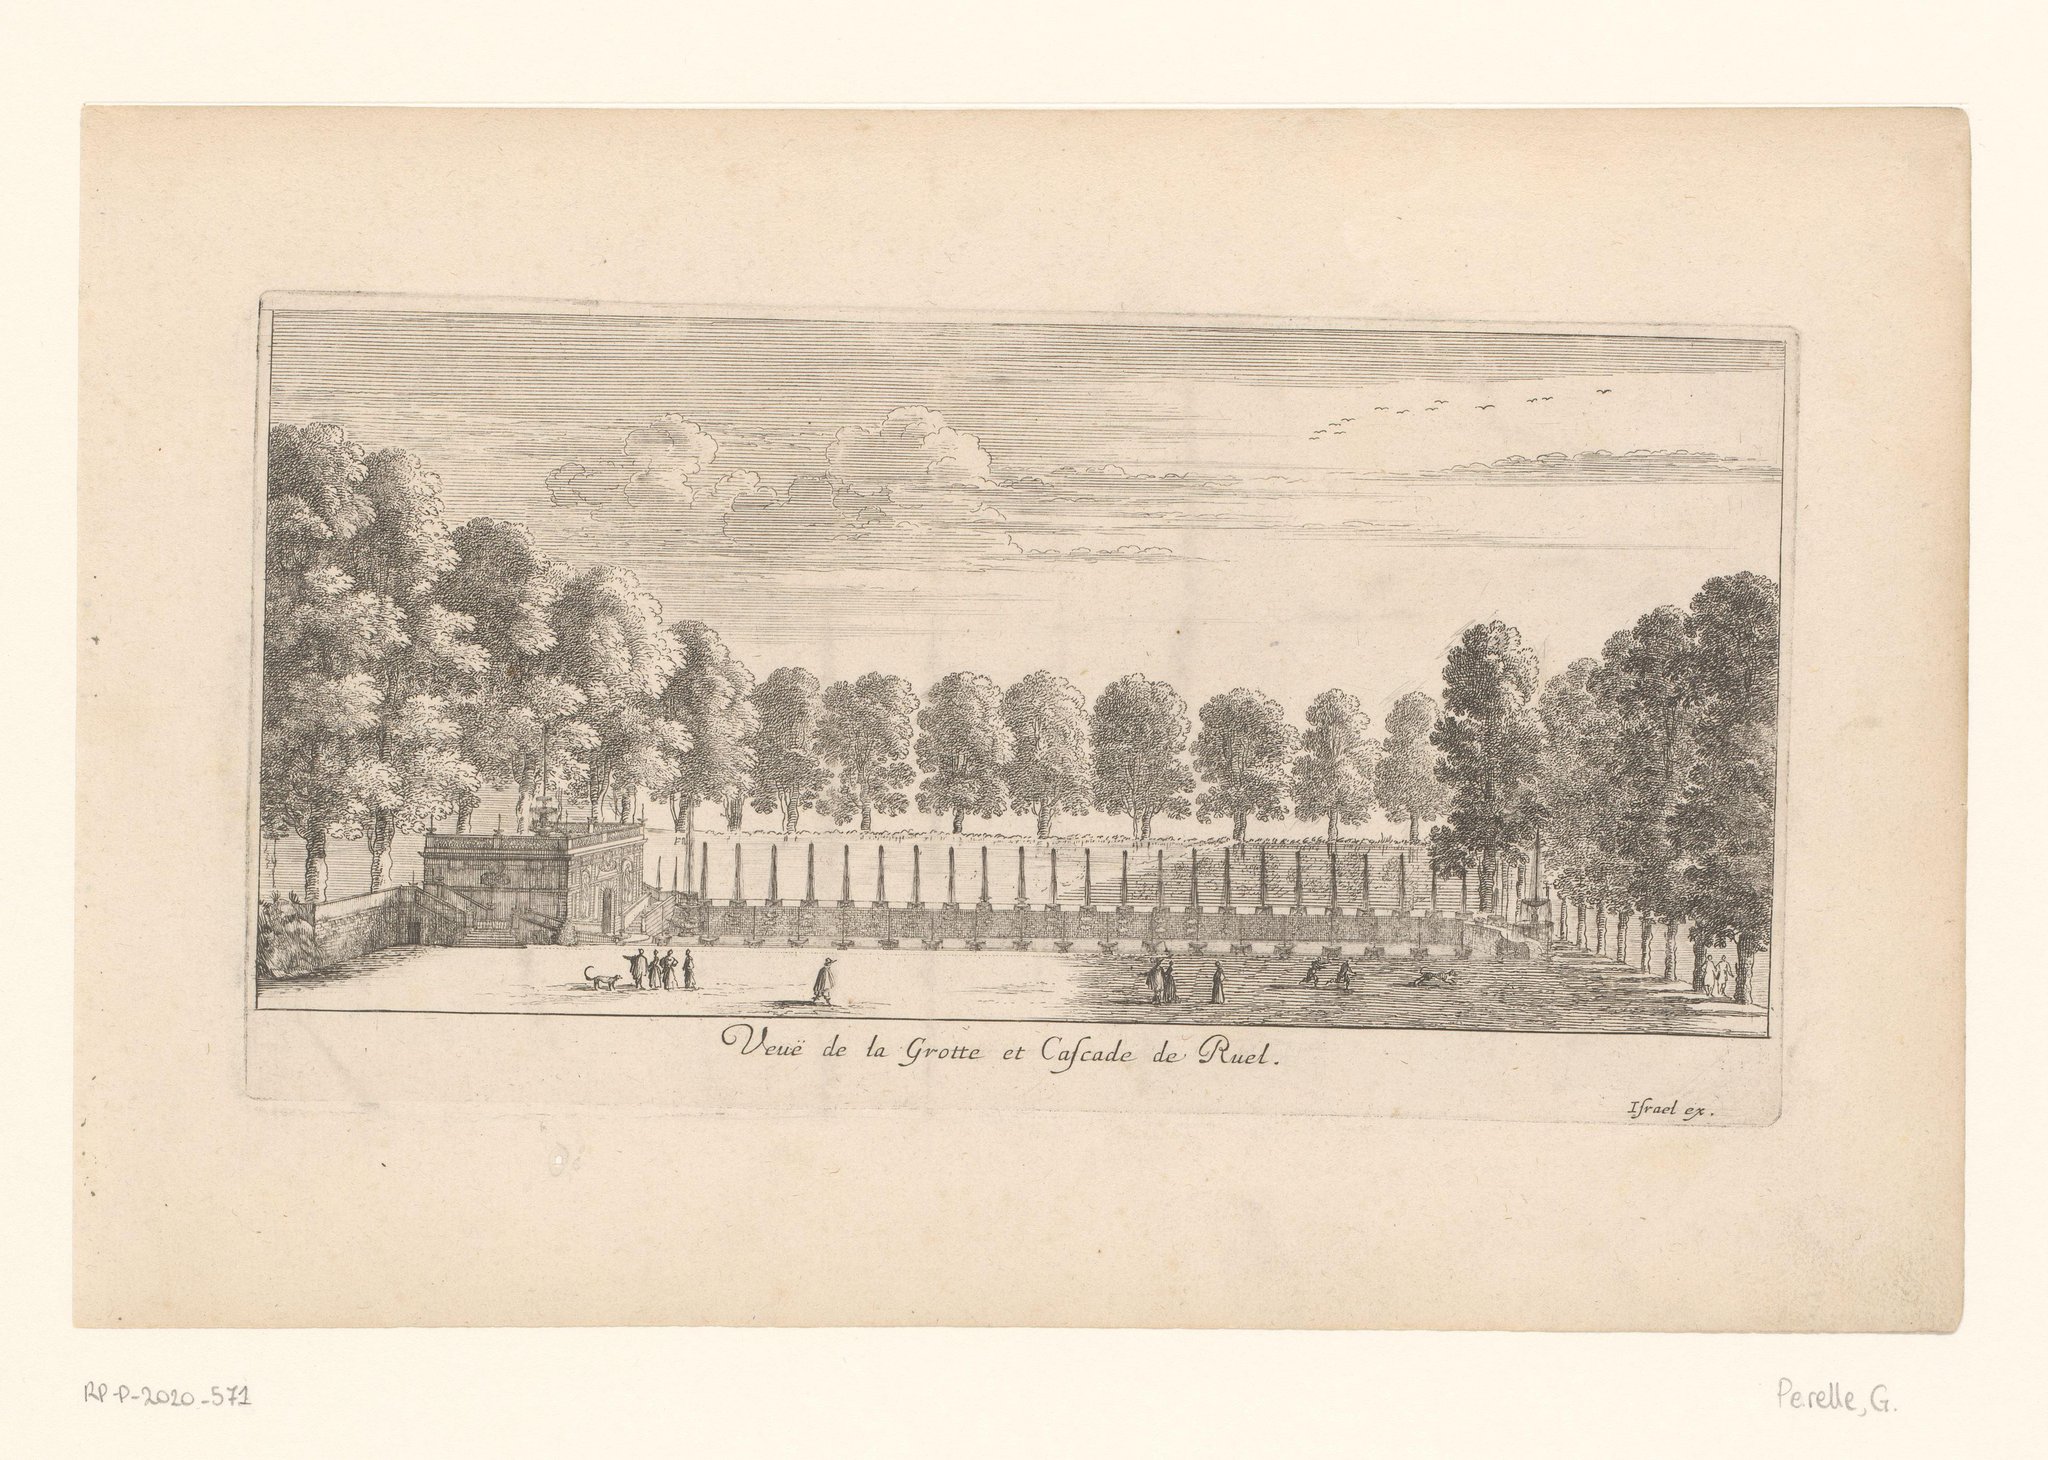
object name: print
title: Veuë de la Grotte et Cascade de Ruel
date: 1654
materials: paper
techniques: etching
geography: paris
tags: french or architectonic garden; formal garden, artificial grotto in garden, garden cascade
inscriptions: collector's mark: Lugt 2228